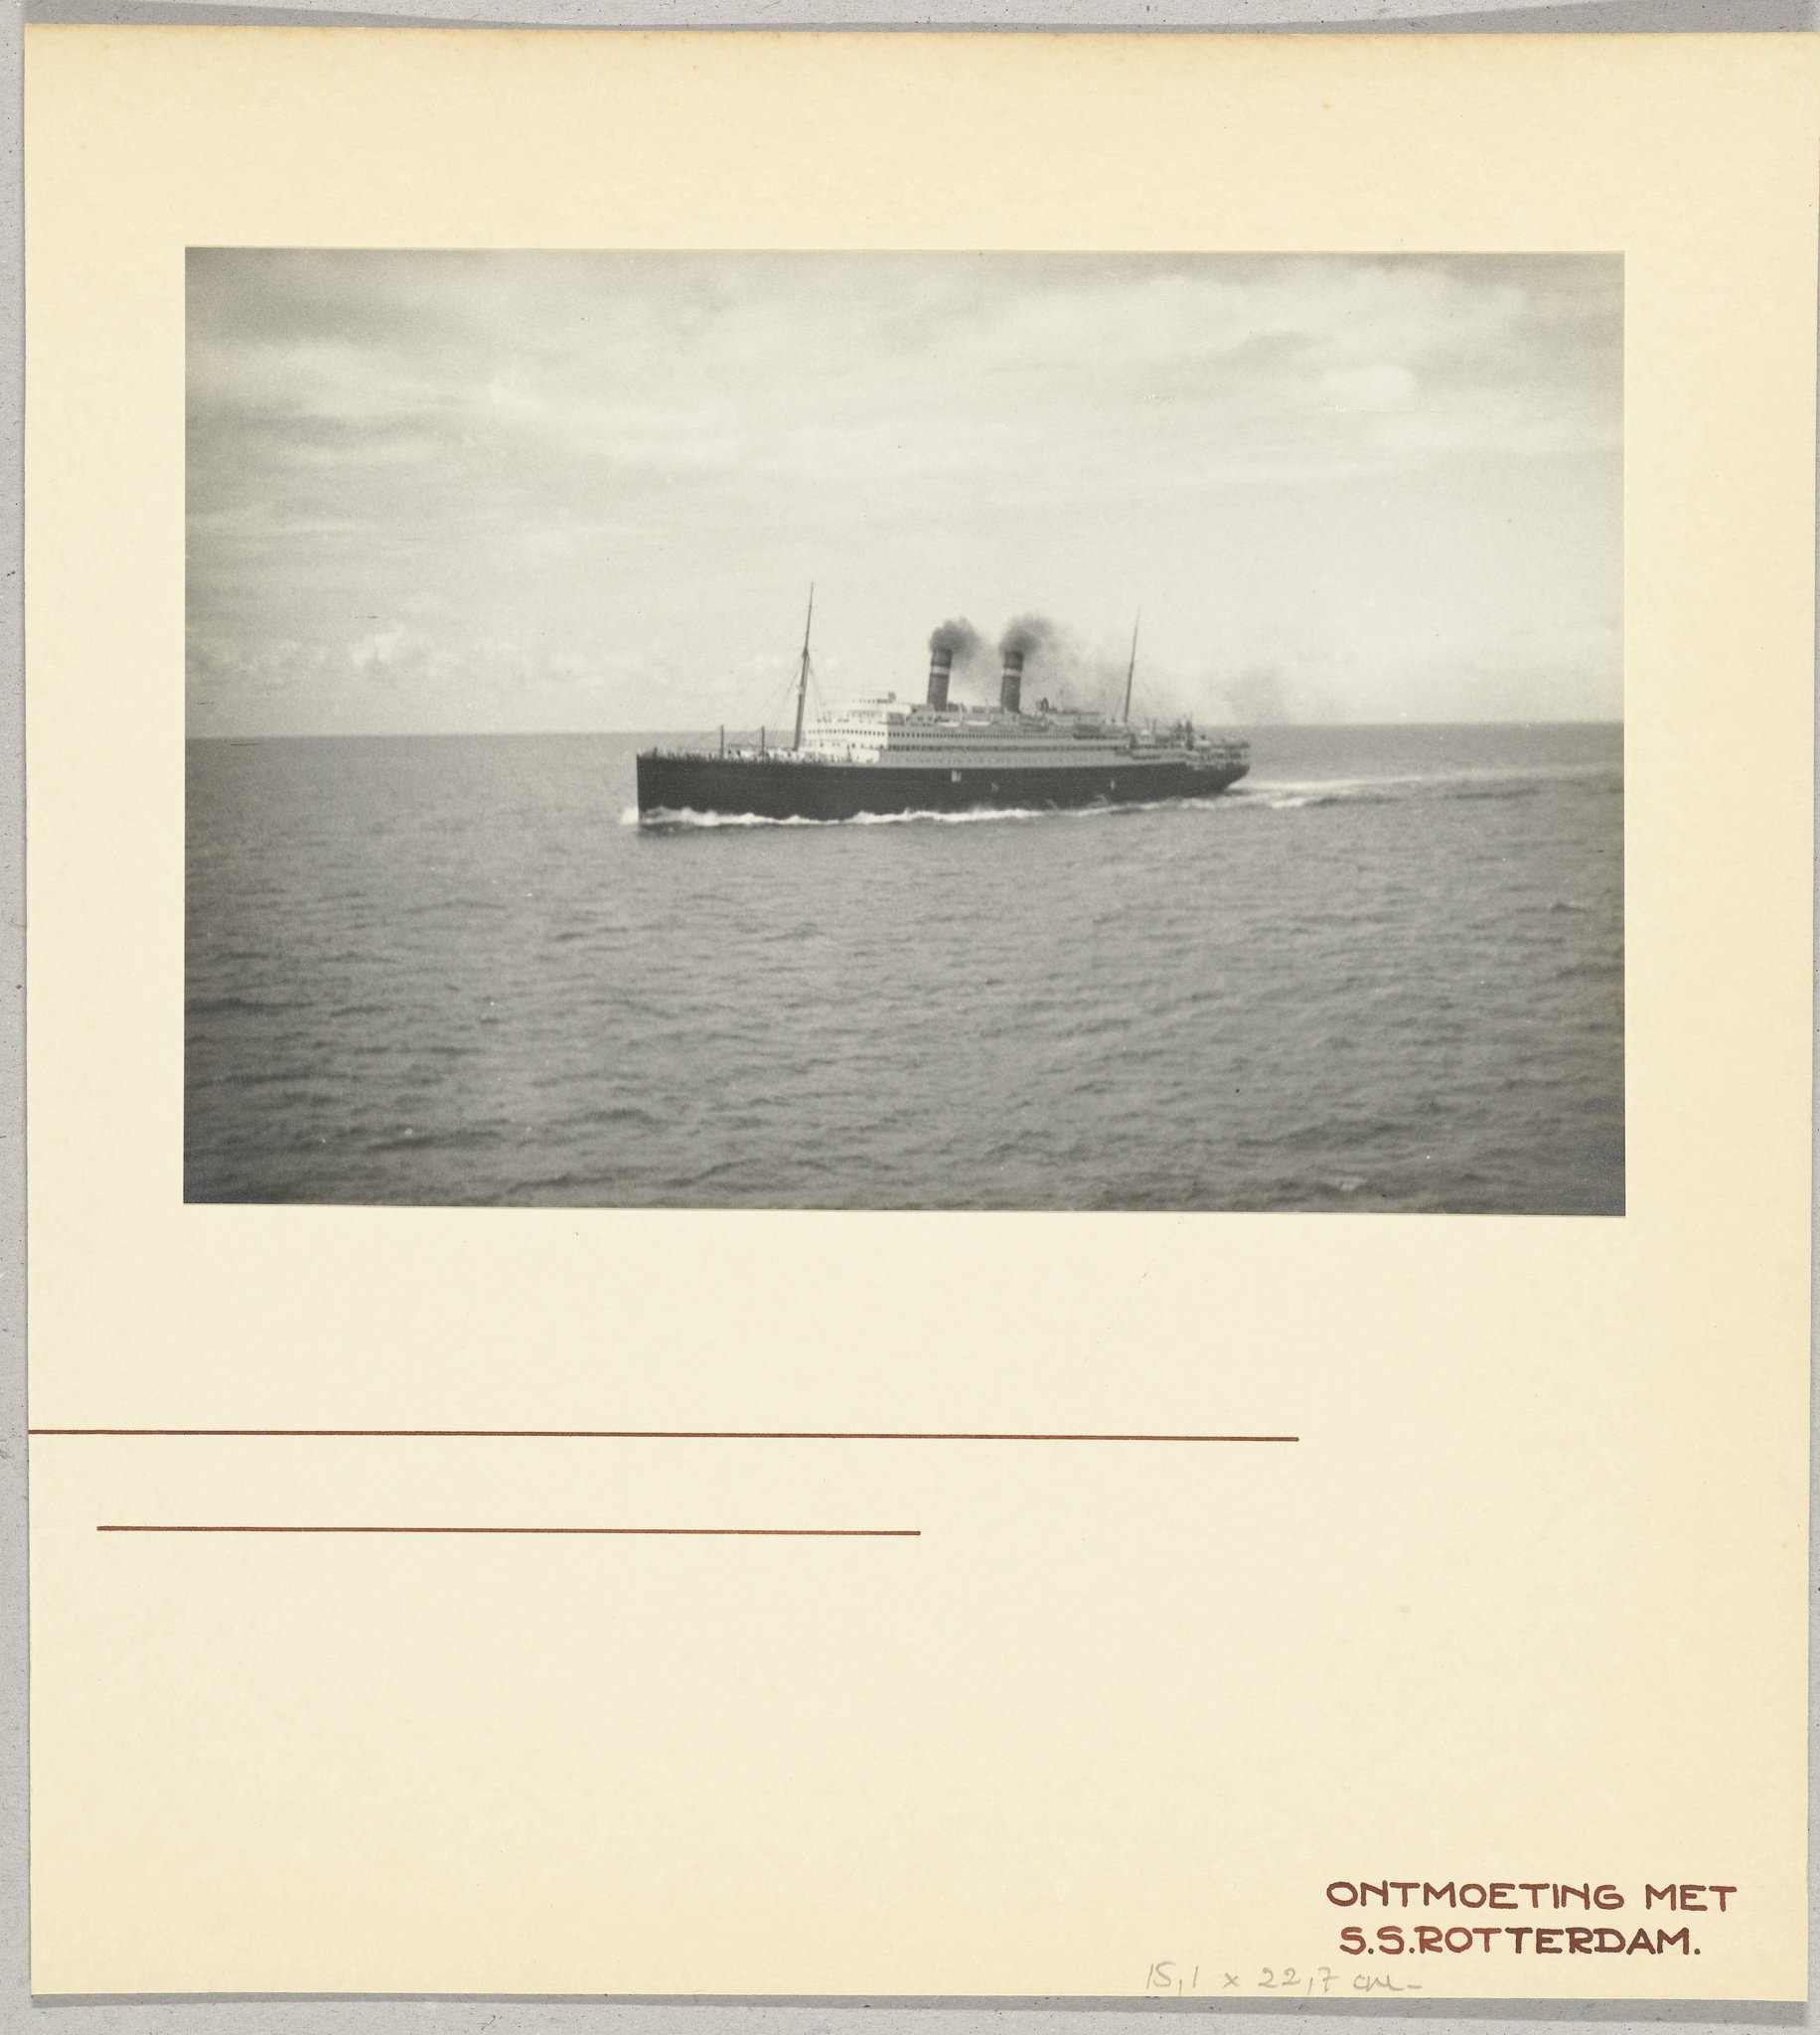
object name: photograph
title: Ontmoeting met S.S. Rotterdam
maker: wouter cool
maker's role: engineer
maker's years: 1877-1947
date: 1936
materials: cardboard, paper, photographic support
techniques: gelatin silver print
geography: united states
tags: steamship, motorship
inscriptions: title: ‘ONTMOETING MET / S.S. ROTTERDAM.’